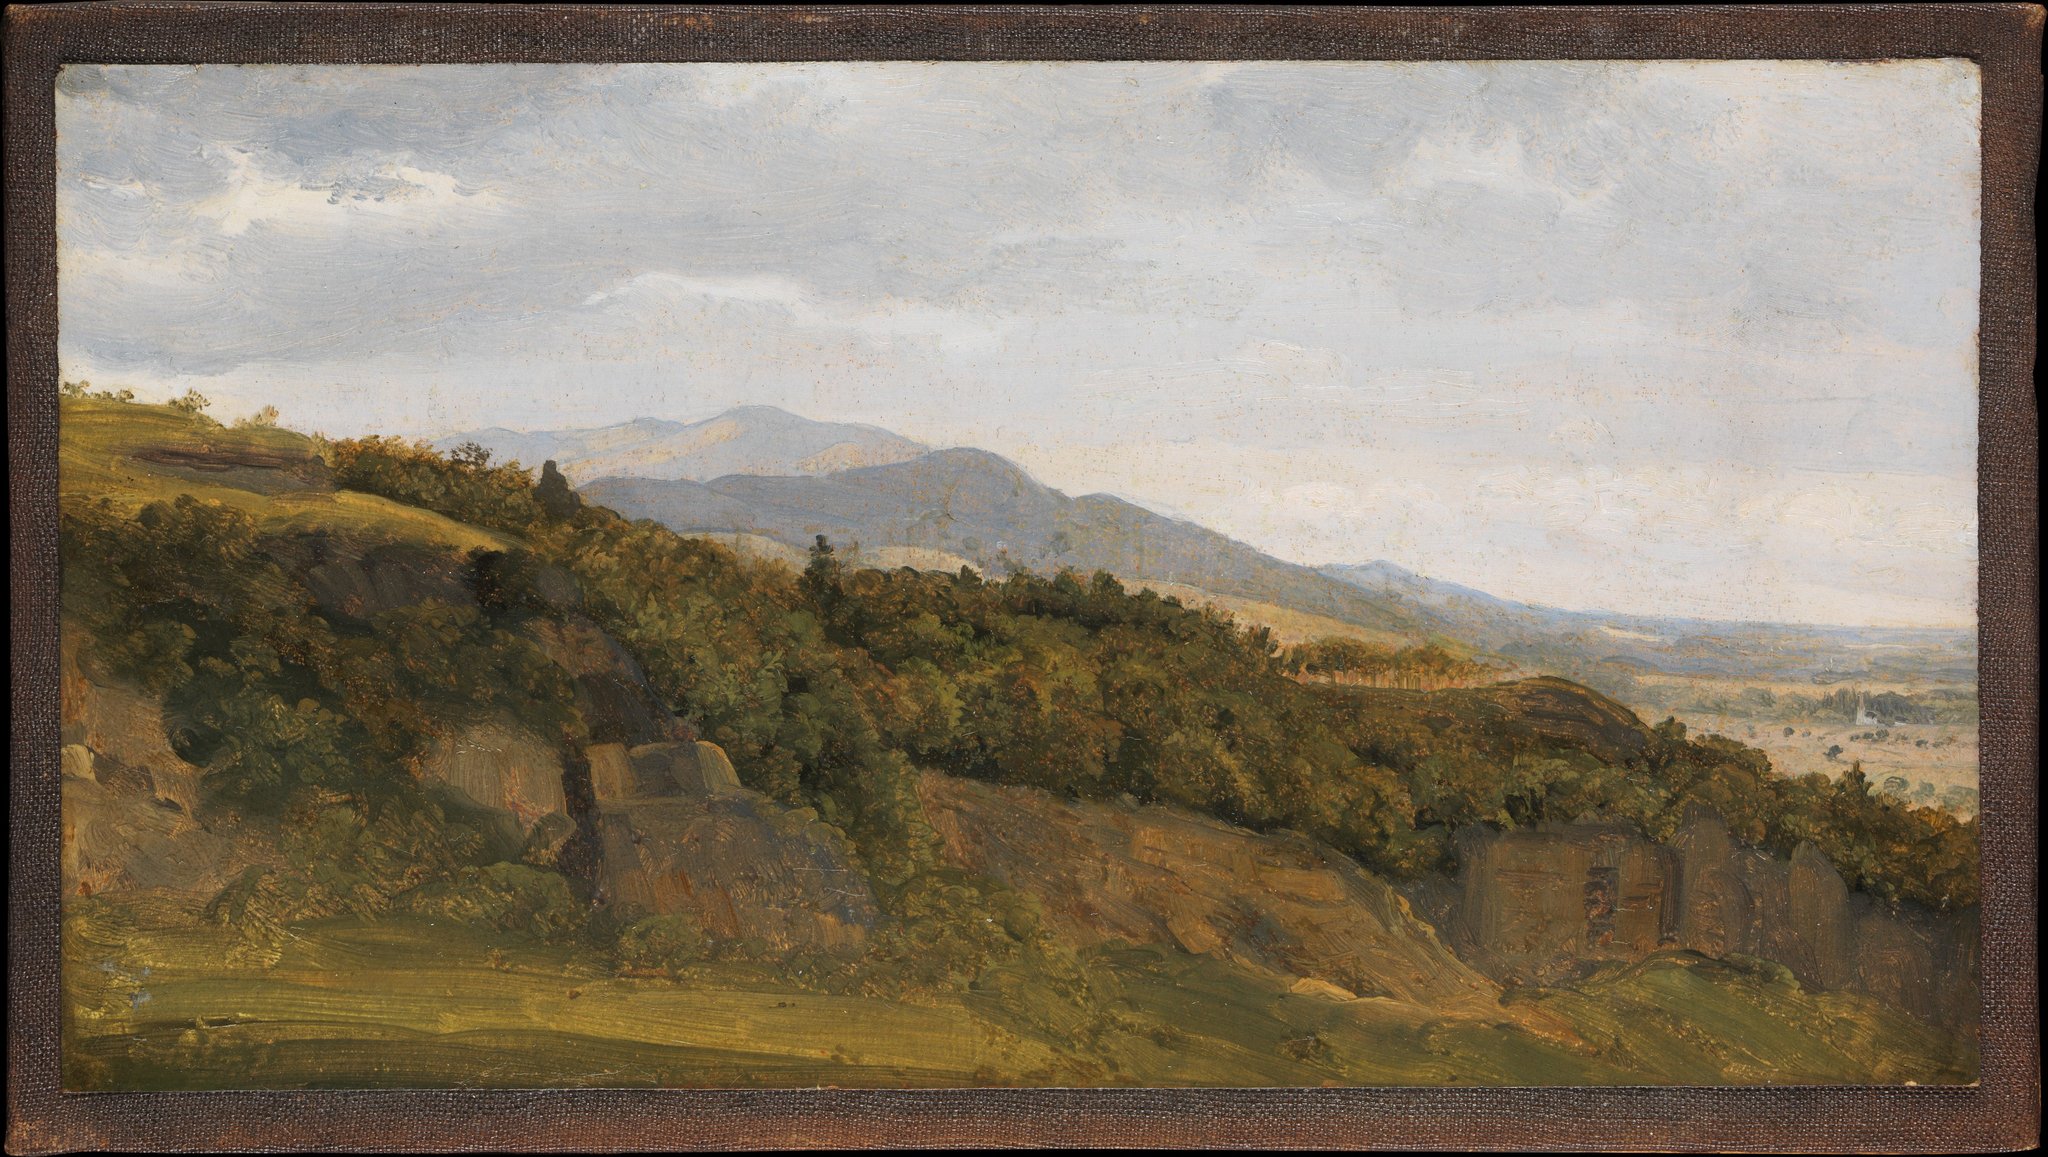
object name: painting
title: German Landscape with View toward a Broad Valley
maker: fritz petzholdt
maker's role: artist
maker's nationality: danish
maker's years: 1805-1838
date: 1829-1830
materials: canvas, oil, paper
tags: mountains,landscapes